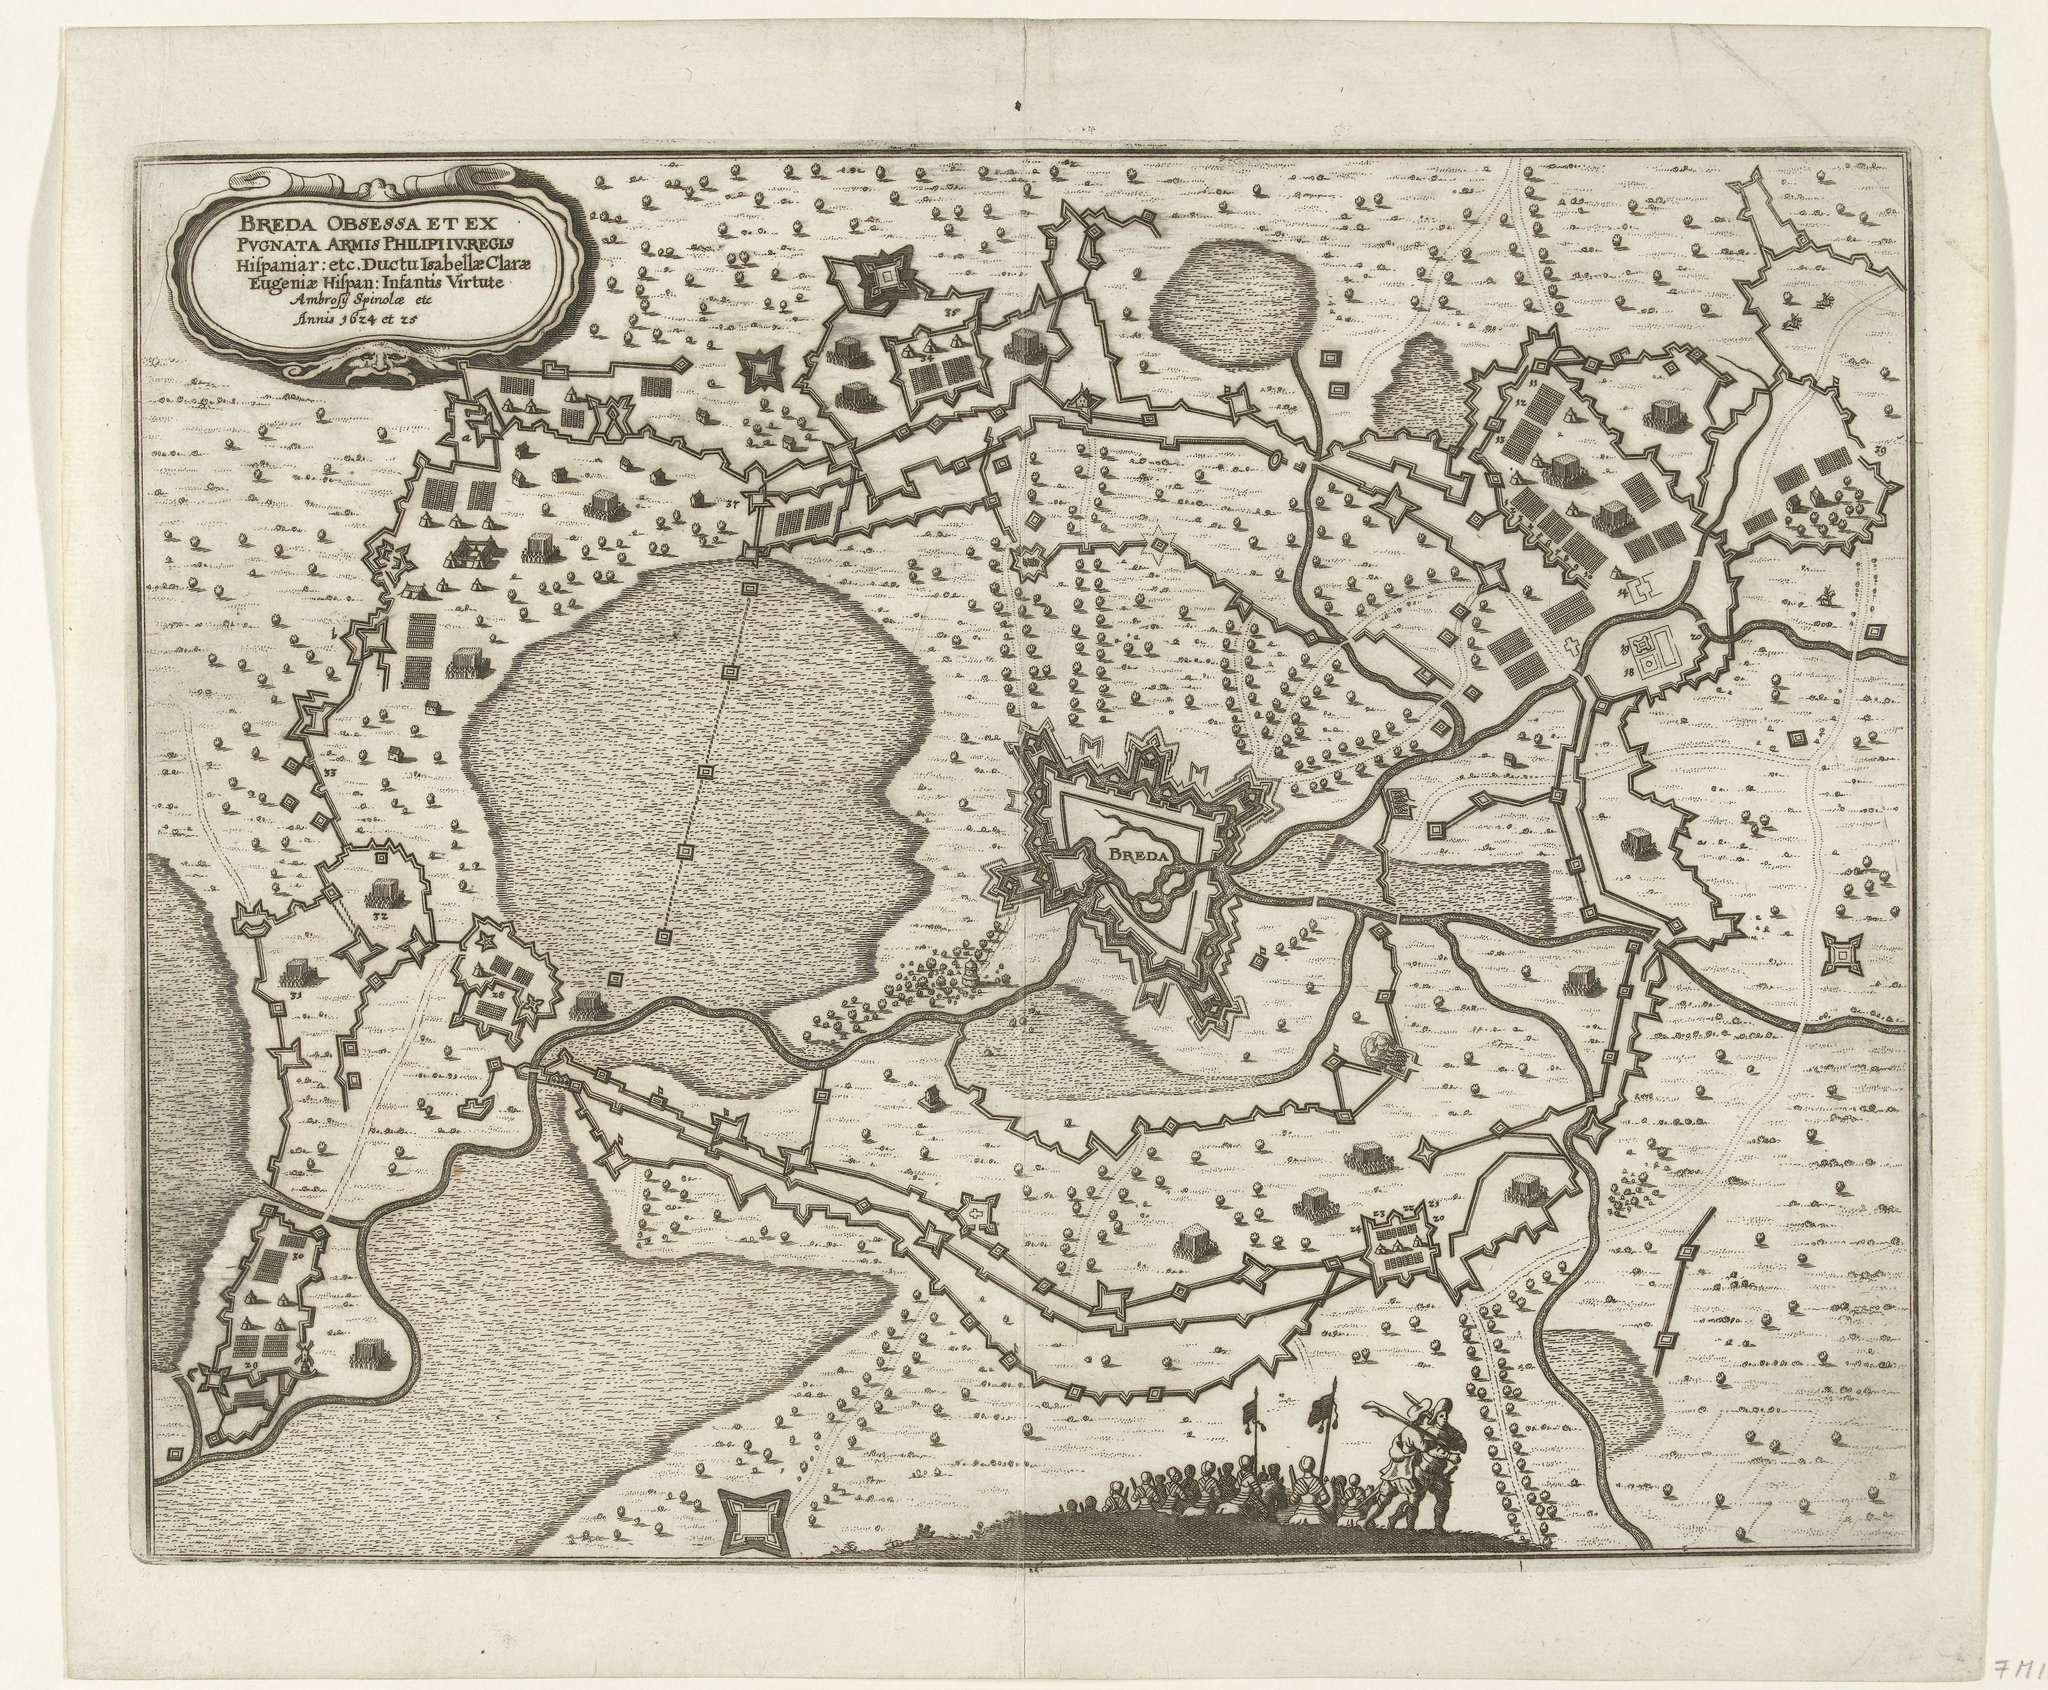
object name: print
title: Kaart van het beleg van Breda, 1624-1625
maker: Anonymous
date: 1625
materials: paper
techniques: etching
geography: germany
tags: maps of separate countries or regions, siege, position war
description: Kaart van het beleg van Breda door het Spaanse leger onder Spinola, 27 augustus 1624 tot 5 juni 1625. Breda met een groot deel van het omliggende land en de legerplaatsen vande belegerende troepen. Links het overstroomde land Op de voorgrond een groep soldaten. Met cijfers in de plaat maar zonder legenda.